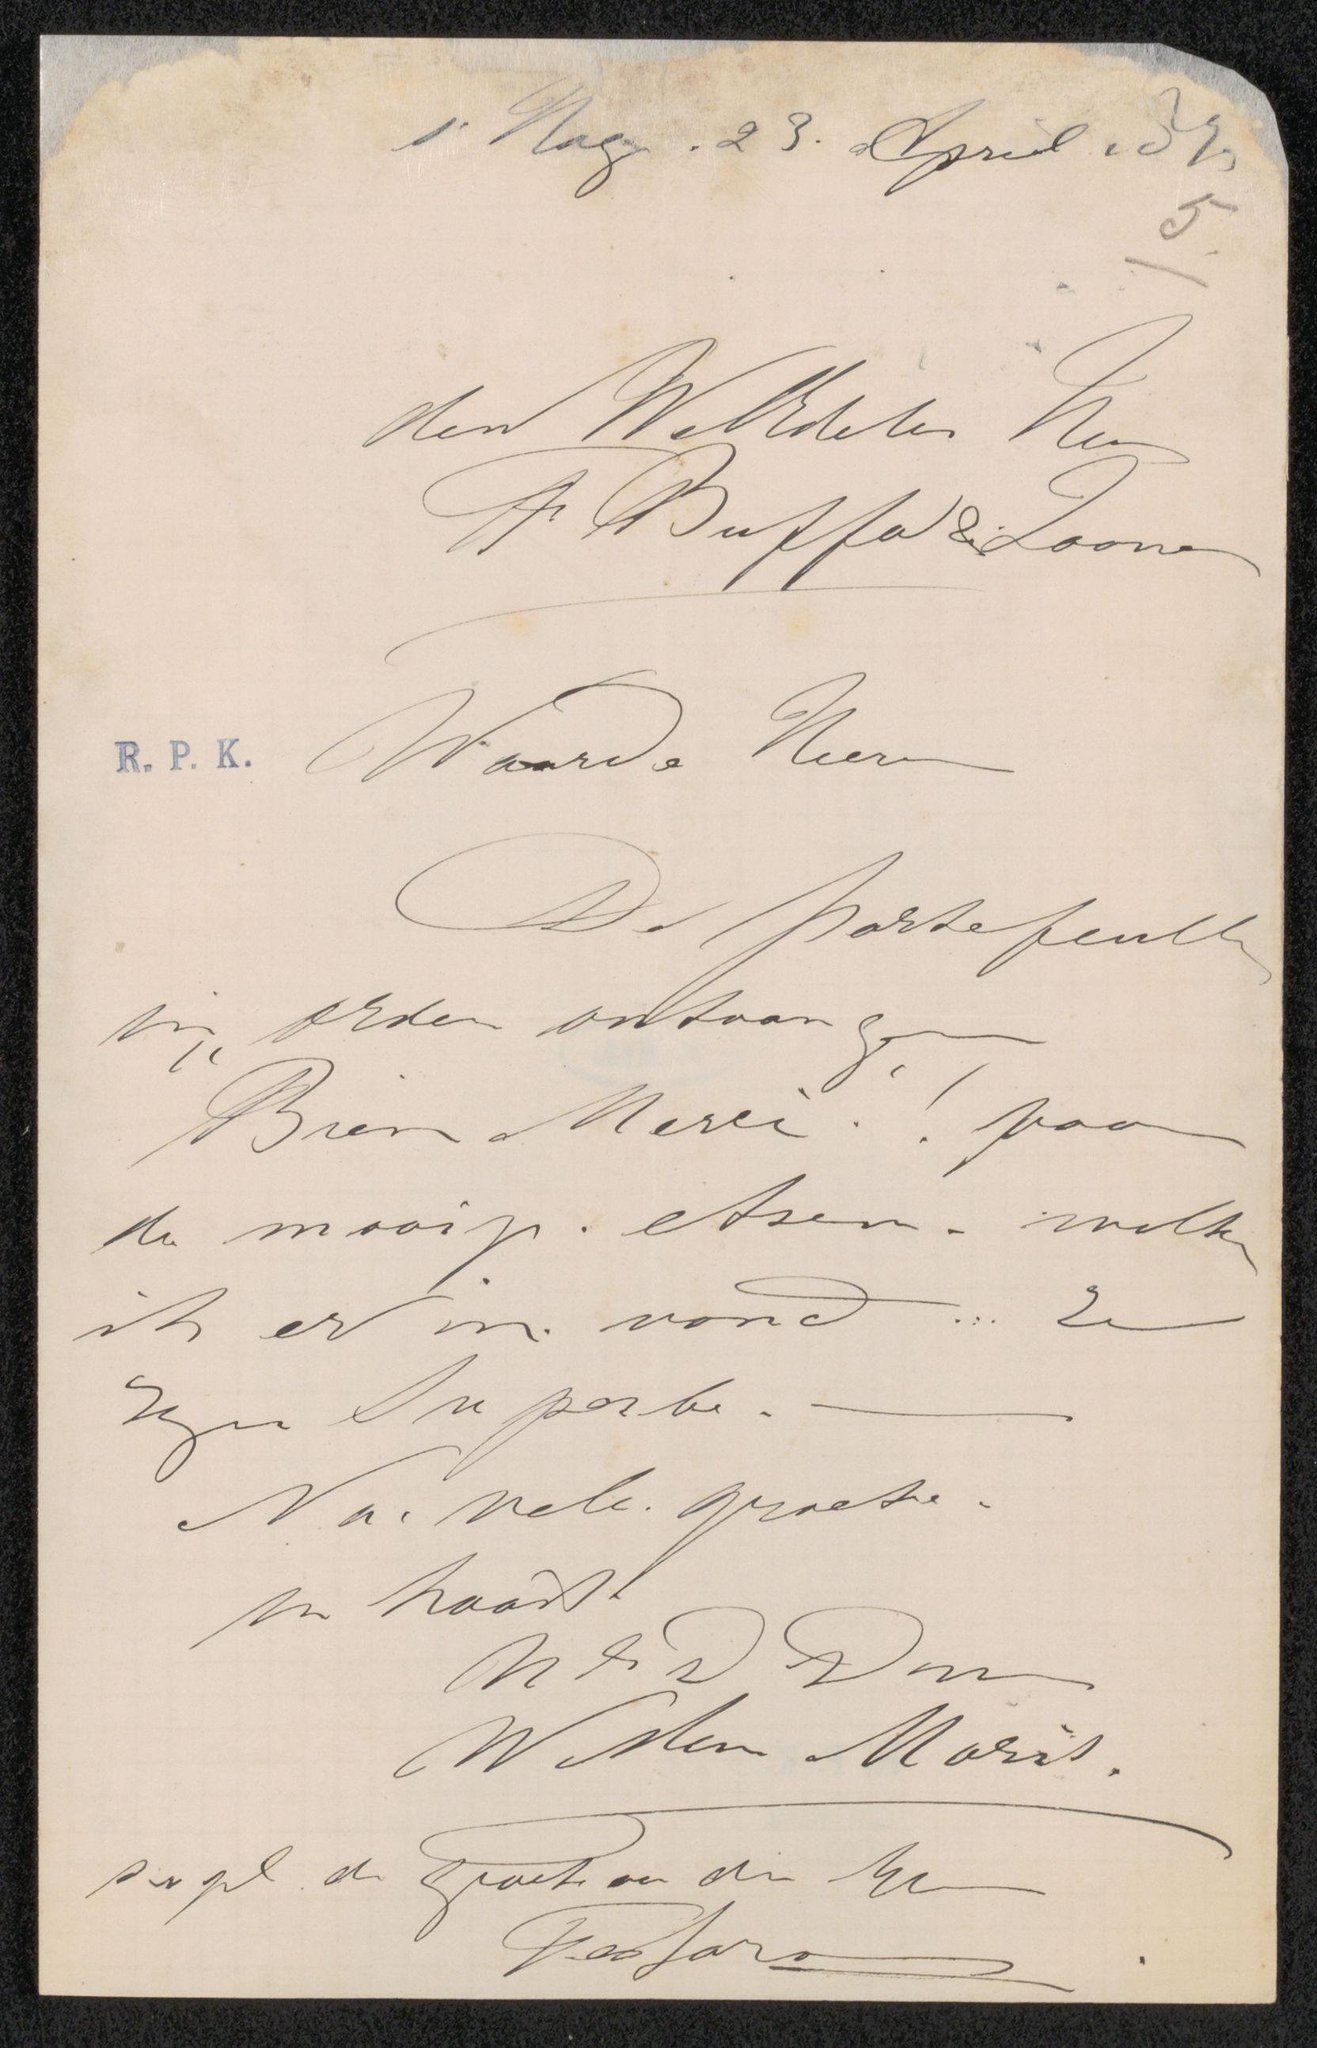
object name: letter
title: Brief aan Frans Buffa en Zonen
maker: willem maris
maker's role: draughtsman, painter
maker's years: 1844-1910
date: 1873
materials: ink, paper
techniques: pen, writing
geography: the hague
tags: amsterdam, publisher, the graphic arts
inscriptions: collector's mark: Lugt 2228, collector's mark: Lugt 2233